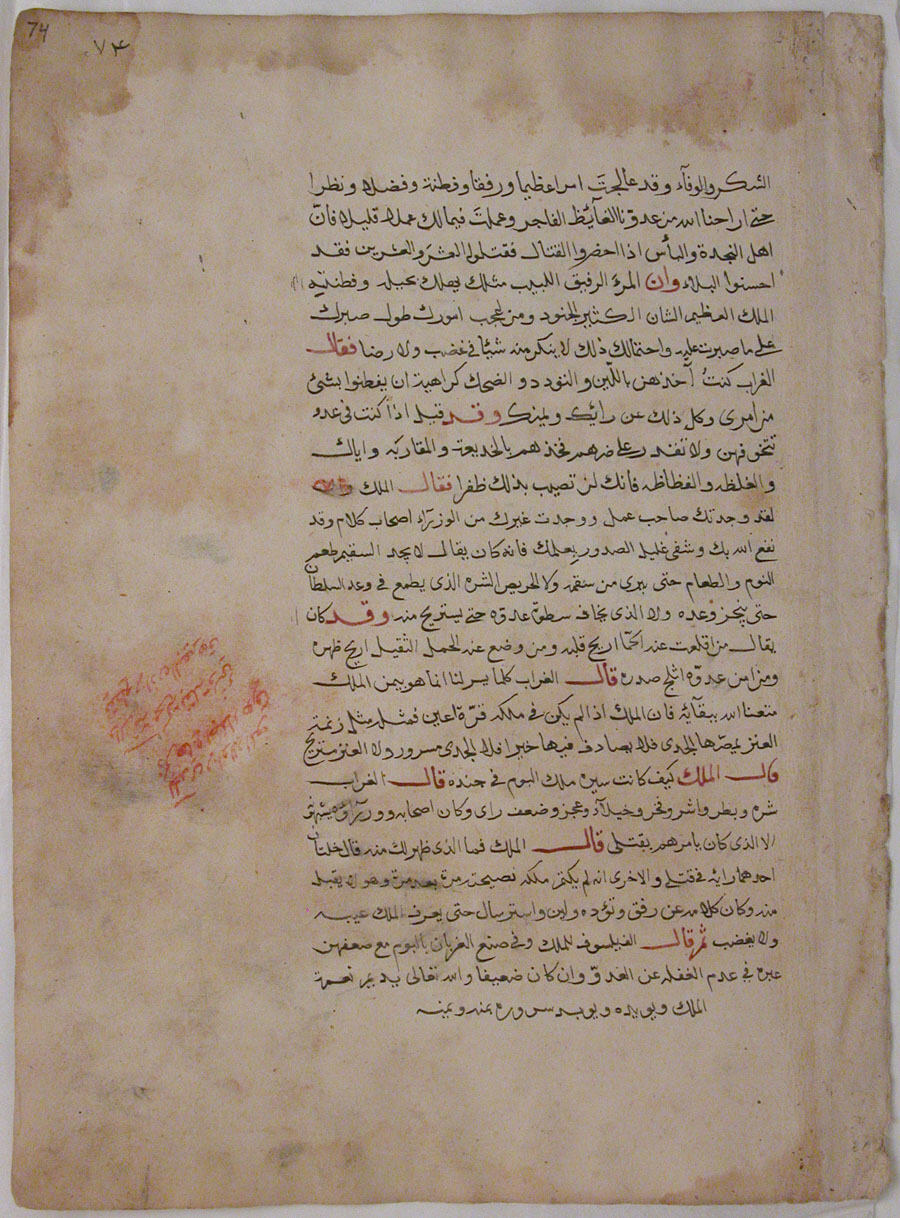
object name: folio from an illustrated manuscript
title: Page of Calligraphy from a Kalila wa Dimna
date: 1526-1550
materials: ink, paper, watercolor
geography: india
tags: arabic,calligraphy